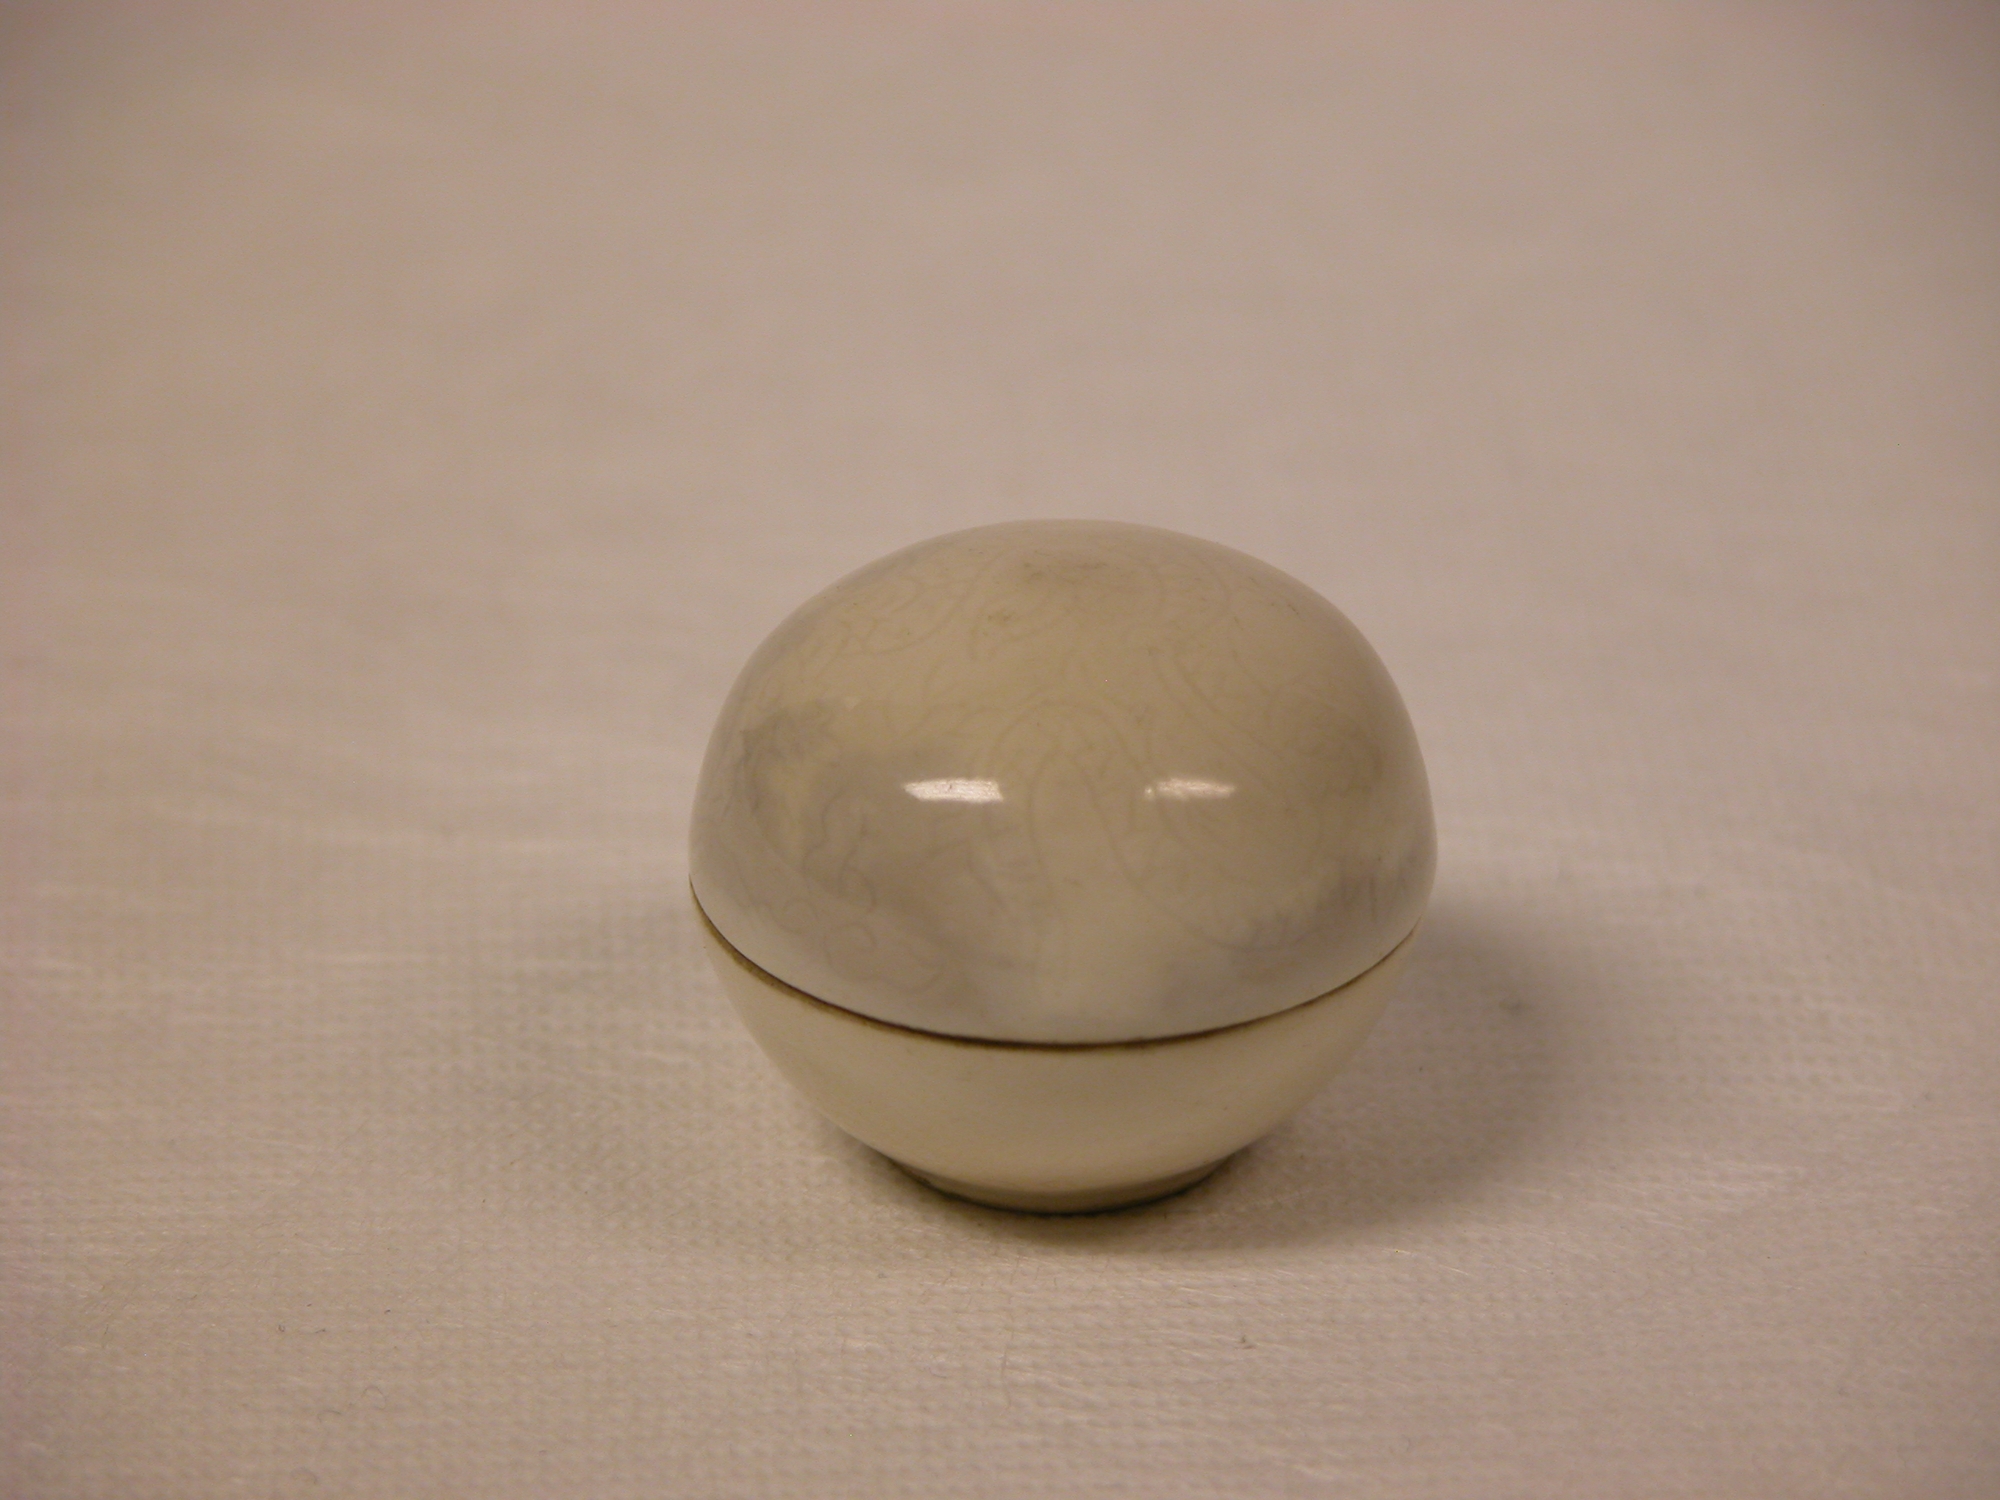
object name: rouge box with cover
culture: chinese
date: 1465-1487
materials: porcelain